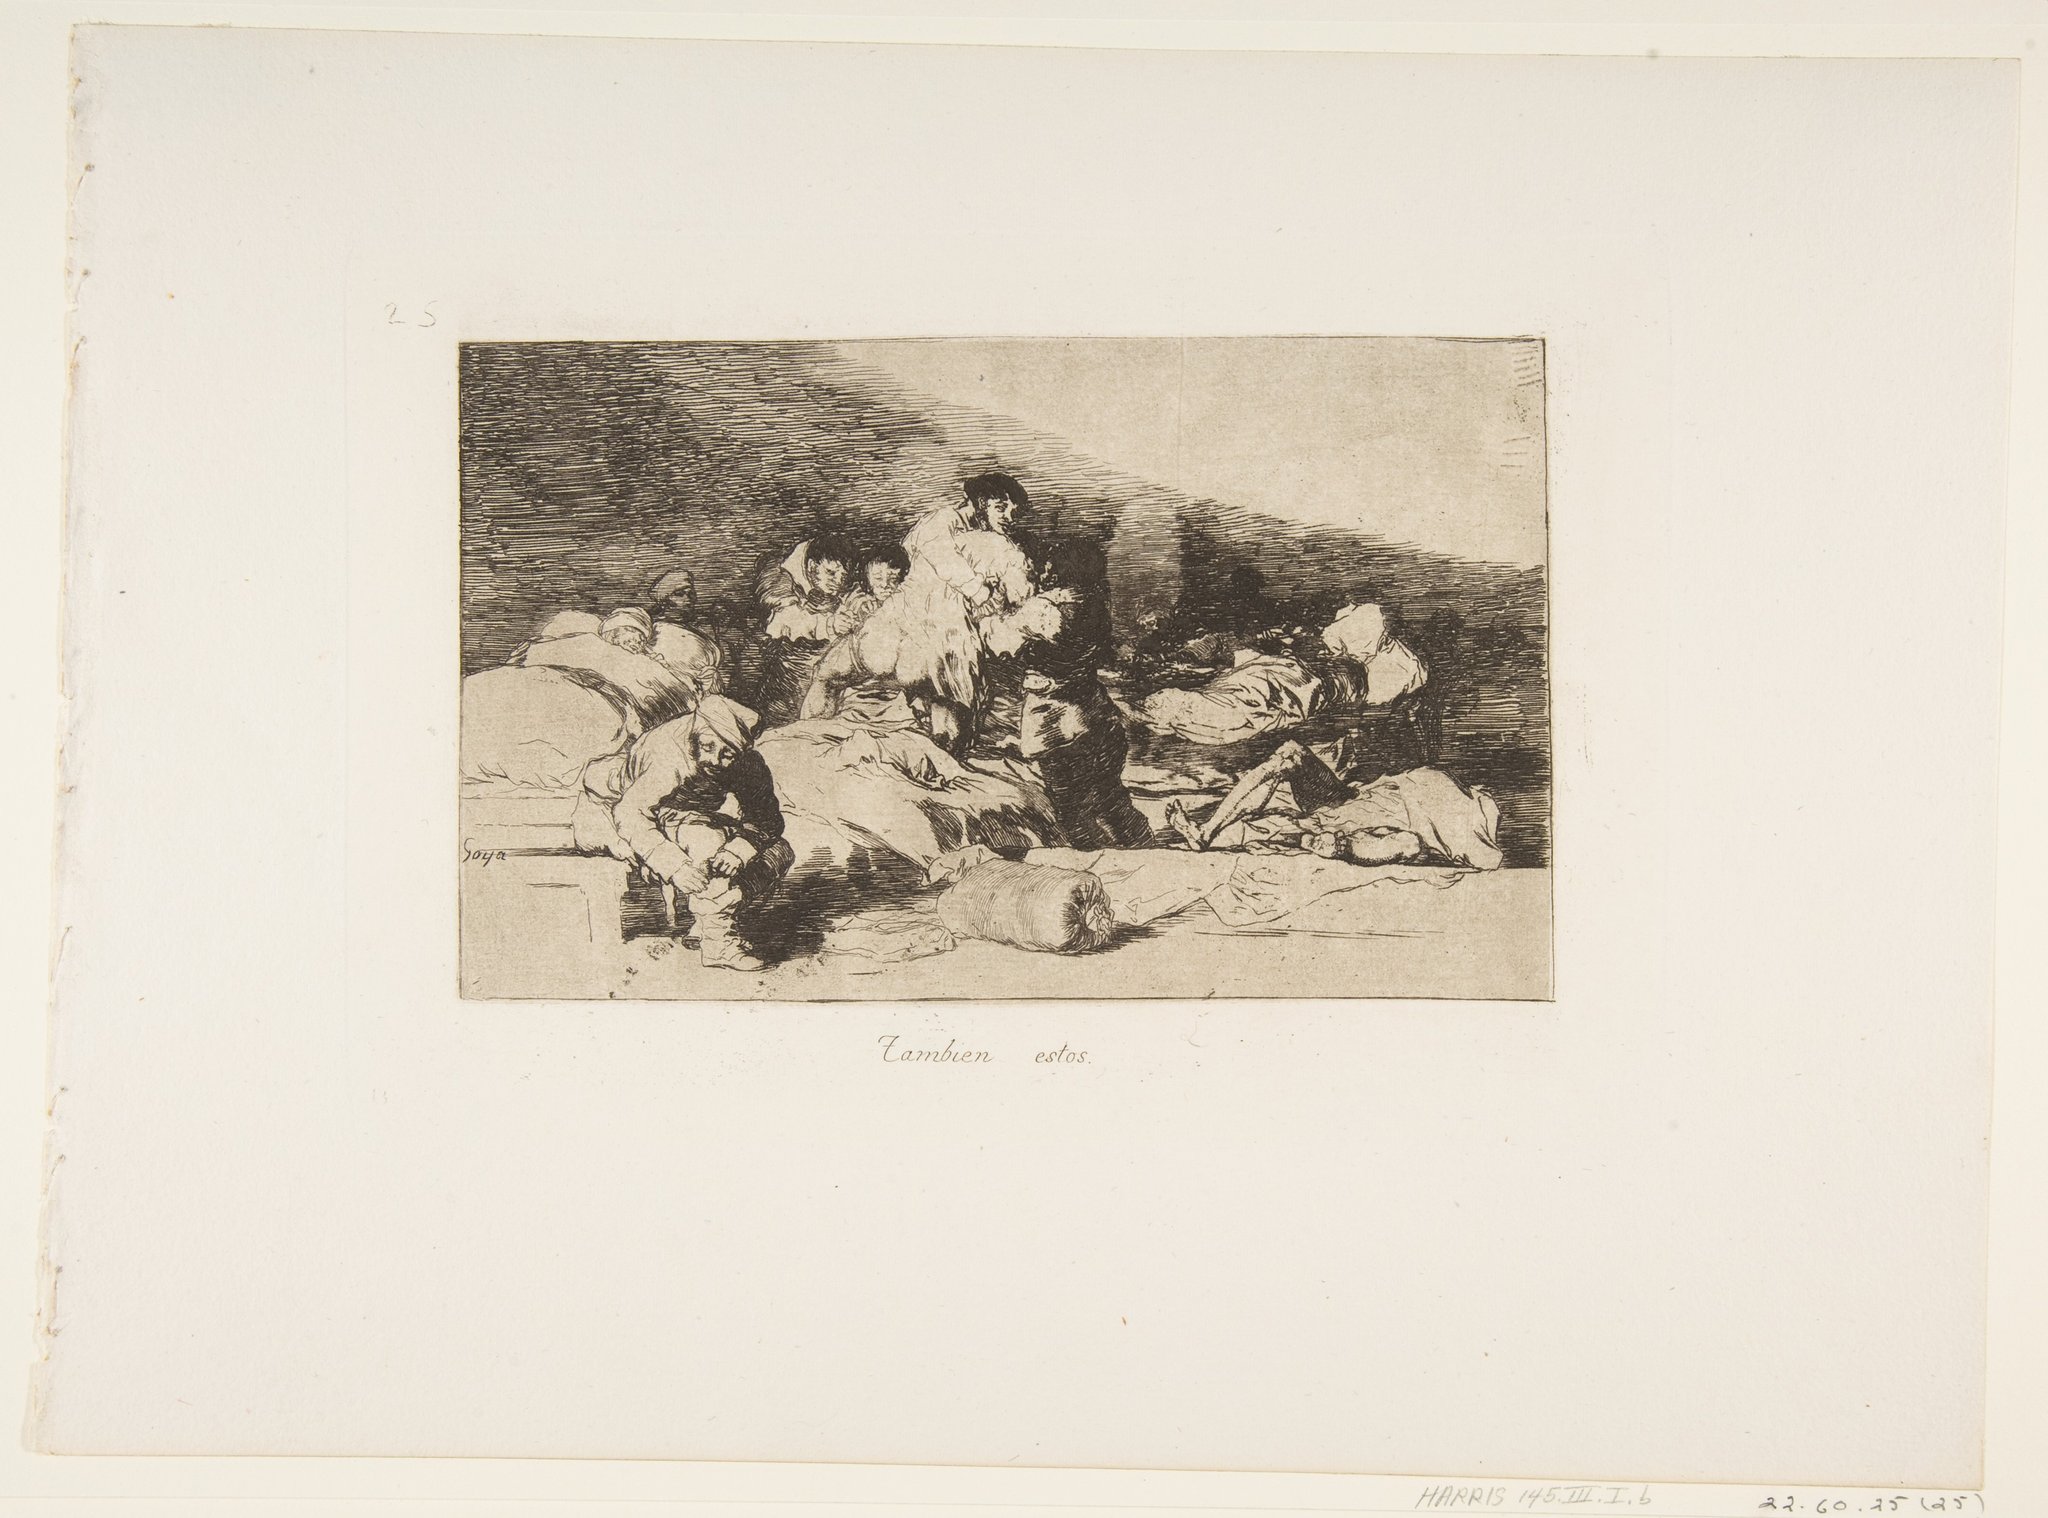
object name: print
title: Plate 25 from "The Disasters of War" (Los Desastres de la Guerra): 'These too' (Tambien estos)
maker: goya (francisco de goya y lucientes)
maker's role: artist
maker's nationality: spanish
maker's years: 1746-1828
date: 1810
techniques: engraving, drypoint, etching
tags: suffering,men